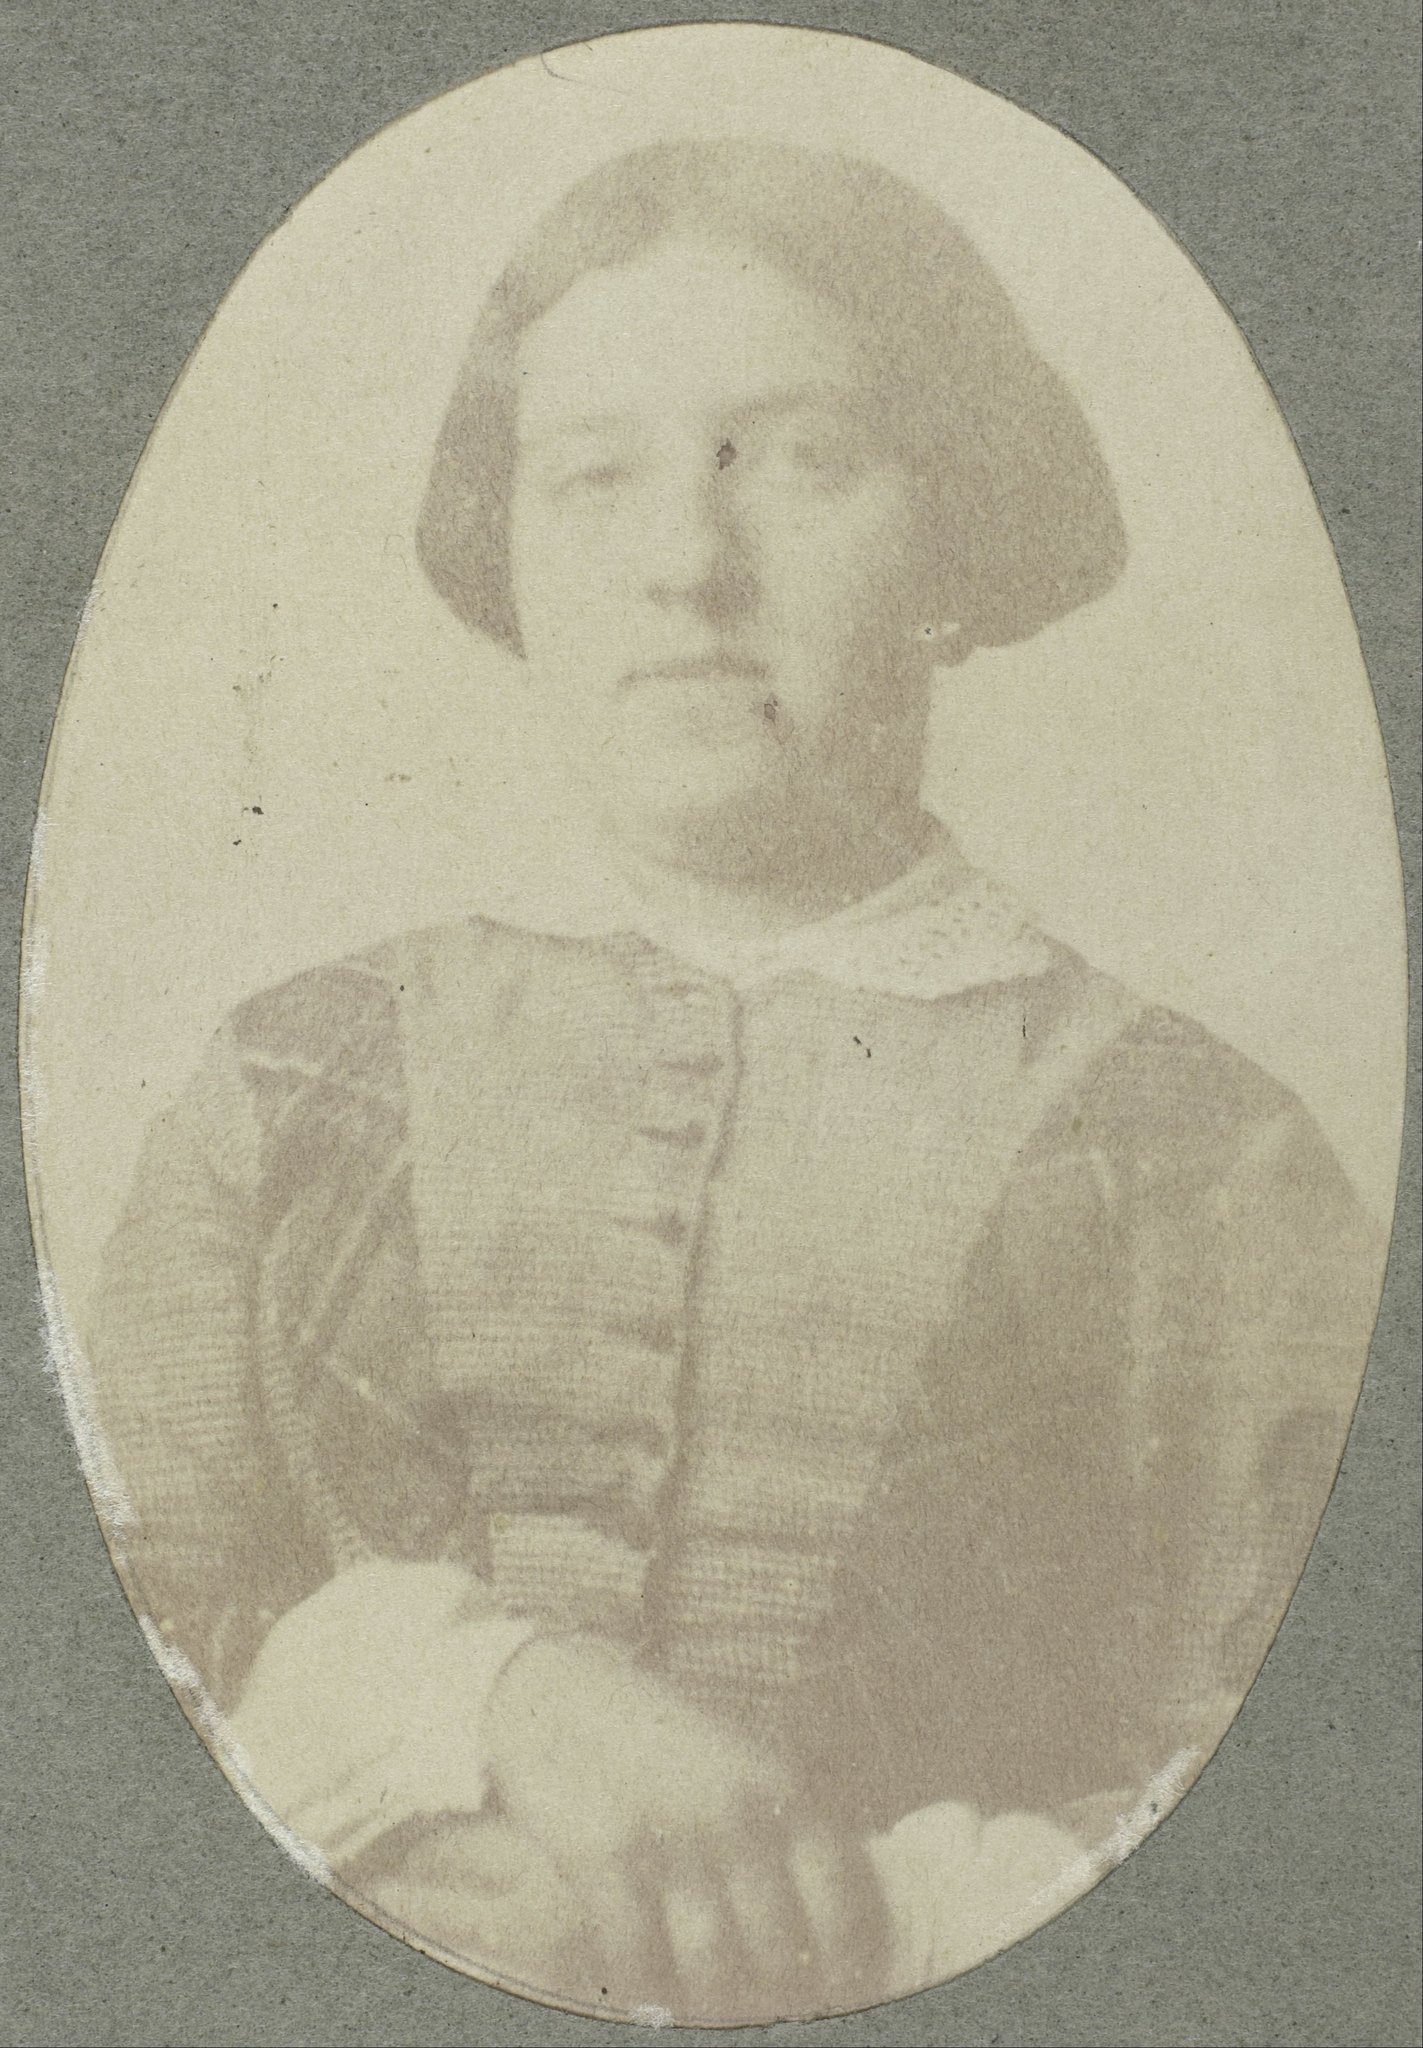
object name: photograph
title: Portret van Charlotte Asser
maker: eduard isaac asser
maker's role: amateurfotograaf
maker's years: 1809-1894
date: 1852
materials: cardboard, paper, photographic support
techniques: salted paper print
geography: amsterdam